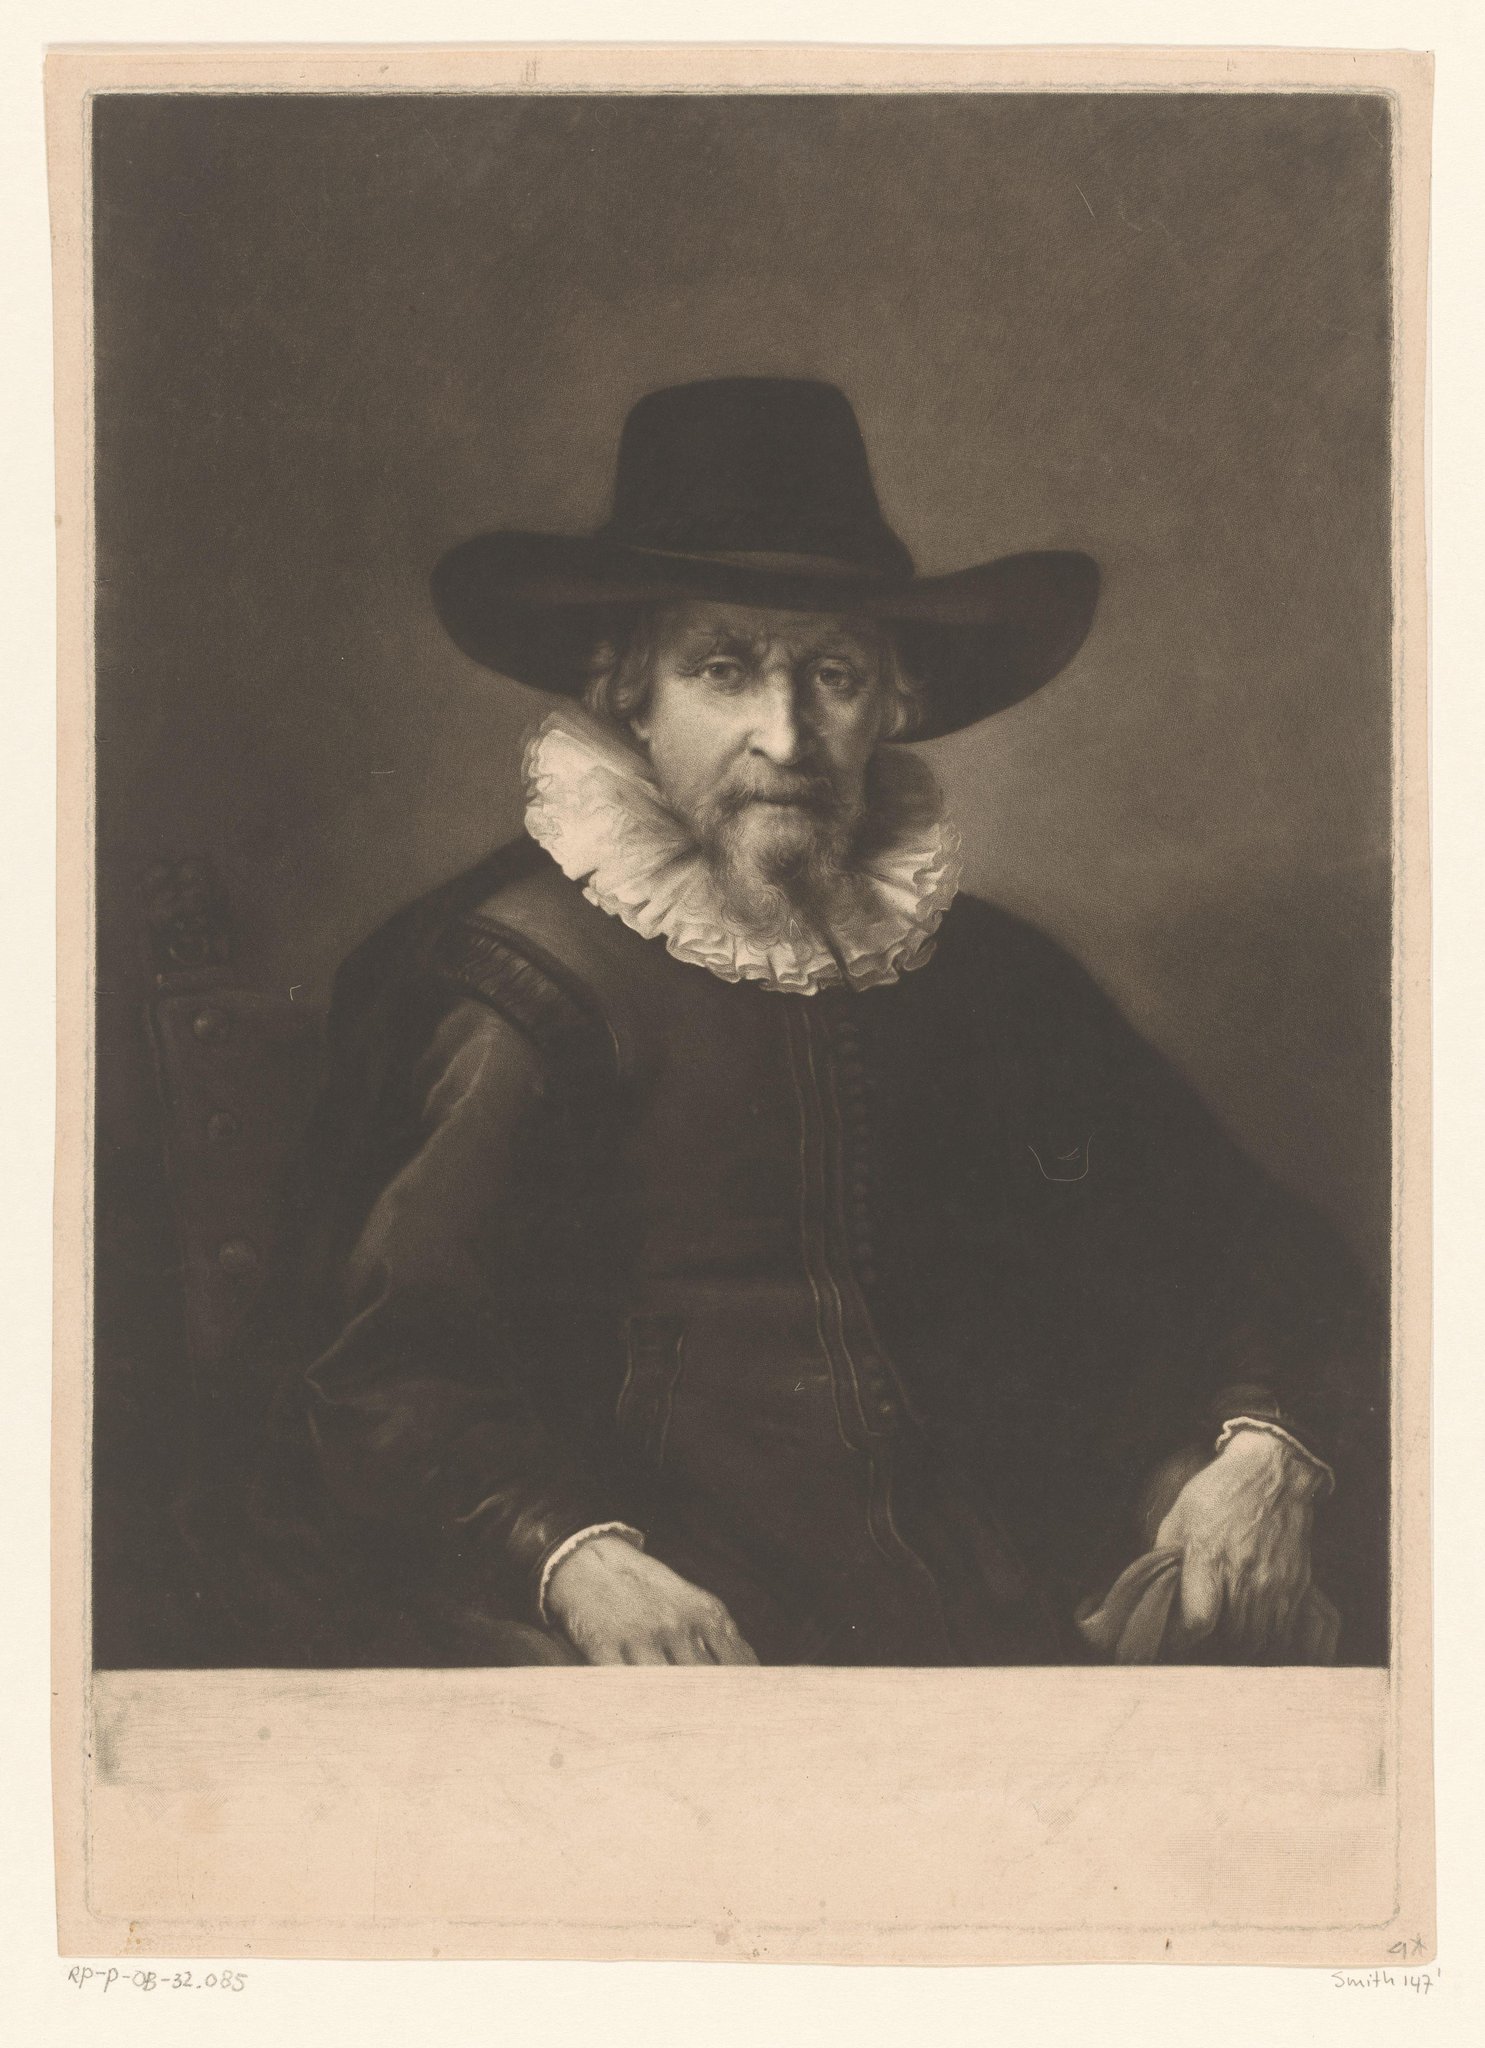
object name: print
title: Portret van een burgemeester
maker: richard houston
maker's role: print maker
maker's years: 1721-1775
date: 1731-1775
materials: paper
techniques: mezzotint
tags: mayor, burgomaster, historical persons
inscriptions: collector's mark: Lugt 240